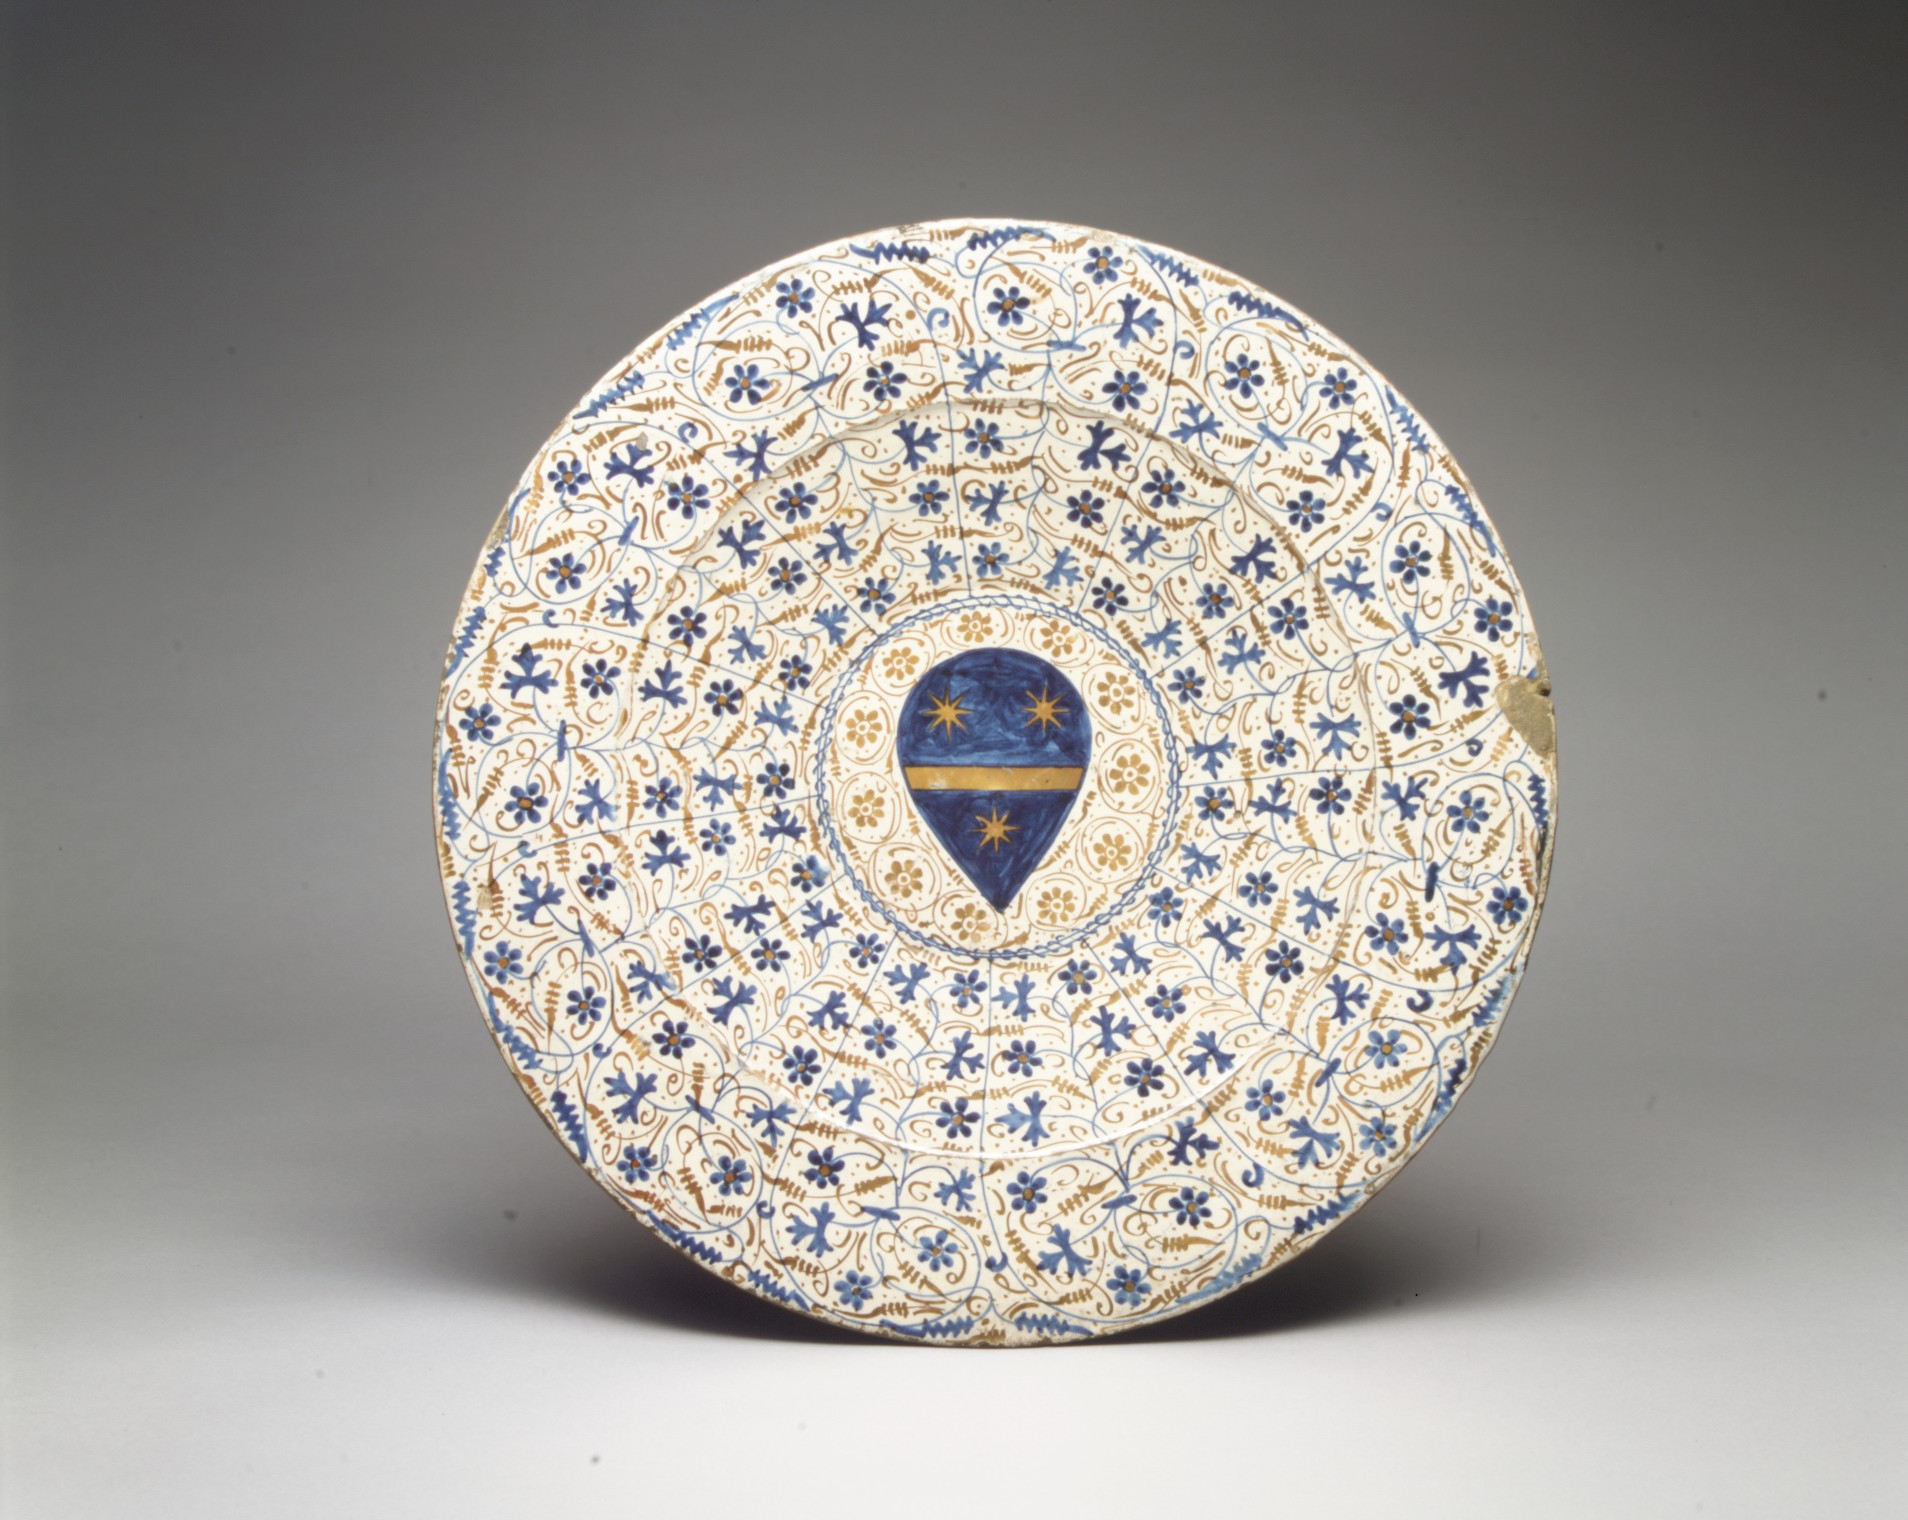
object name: dish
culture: spanish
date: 1430-1460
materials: earthenware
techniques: glazing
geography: spain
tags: coat of arms